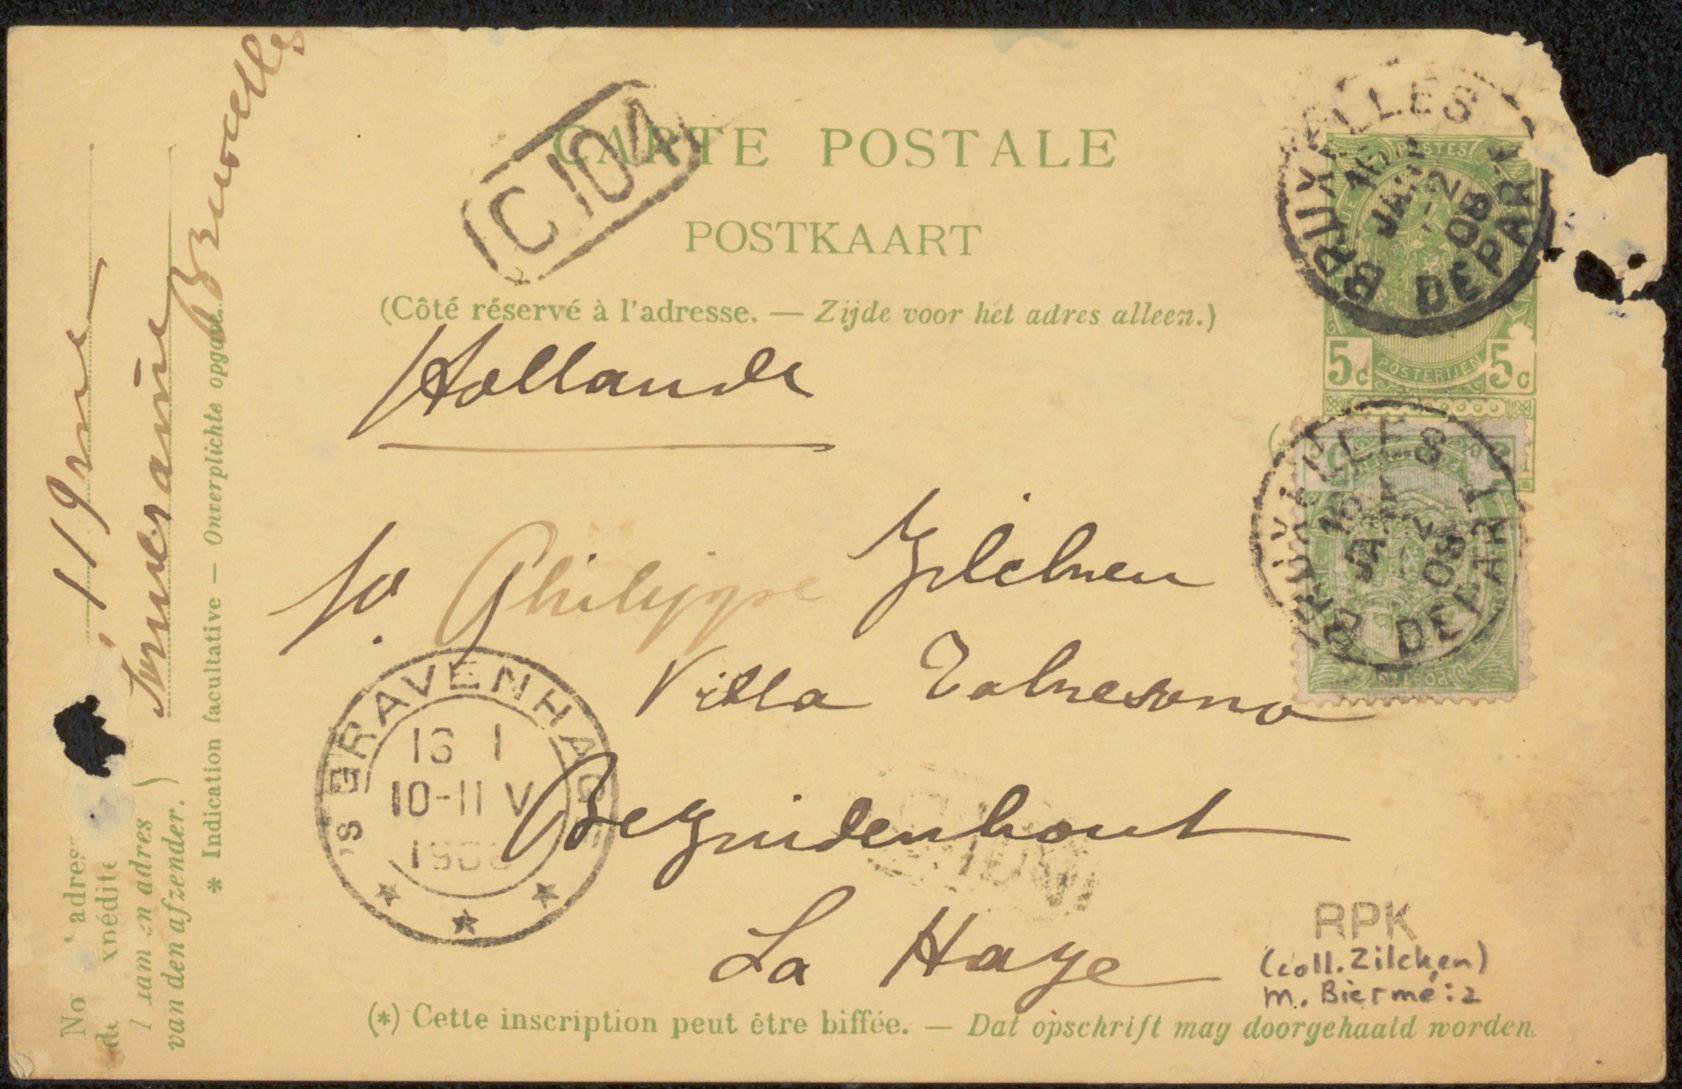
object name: postcard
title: Briefkaart aan Philip Zilcken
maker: maria biermé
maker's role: dichter, schrijver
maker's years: 1863-1932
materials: cardboard, ink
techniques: pen, writing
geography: brussels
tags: the hague, painter, draughtsman, philip zilcken, the graphic arts, diseases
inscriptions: collector's mark: ‘RPK’